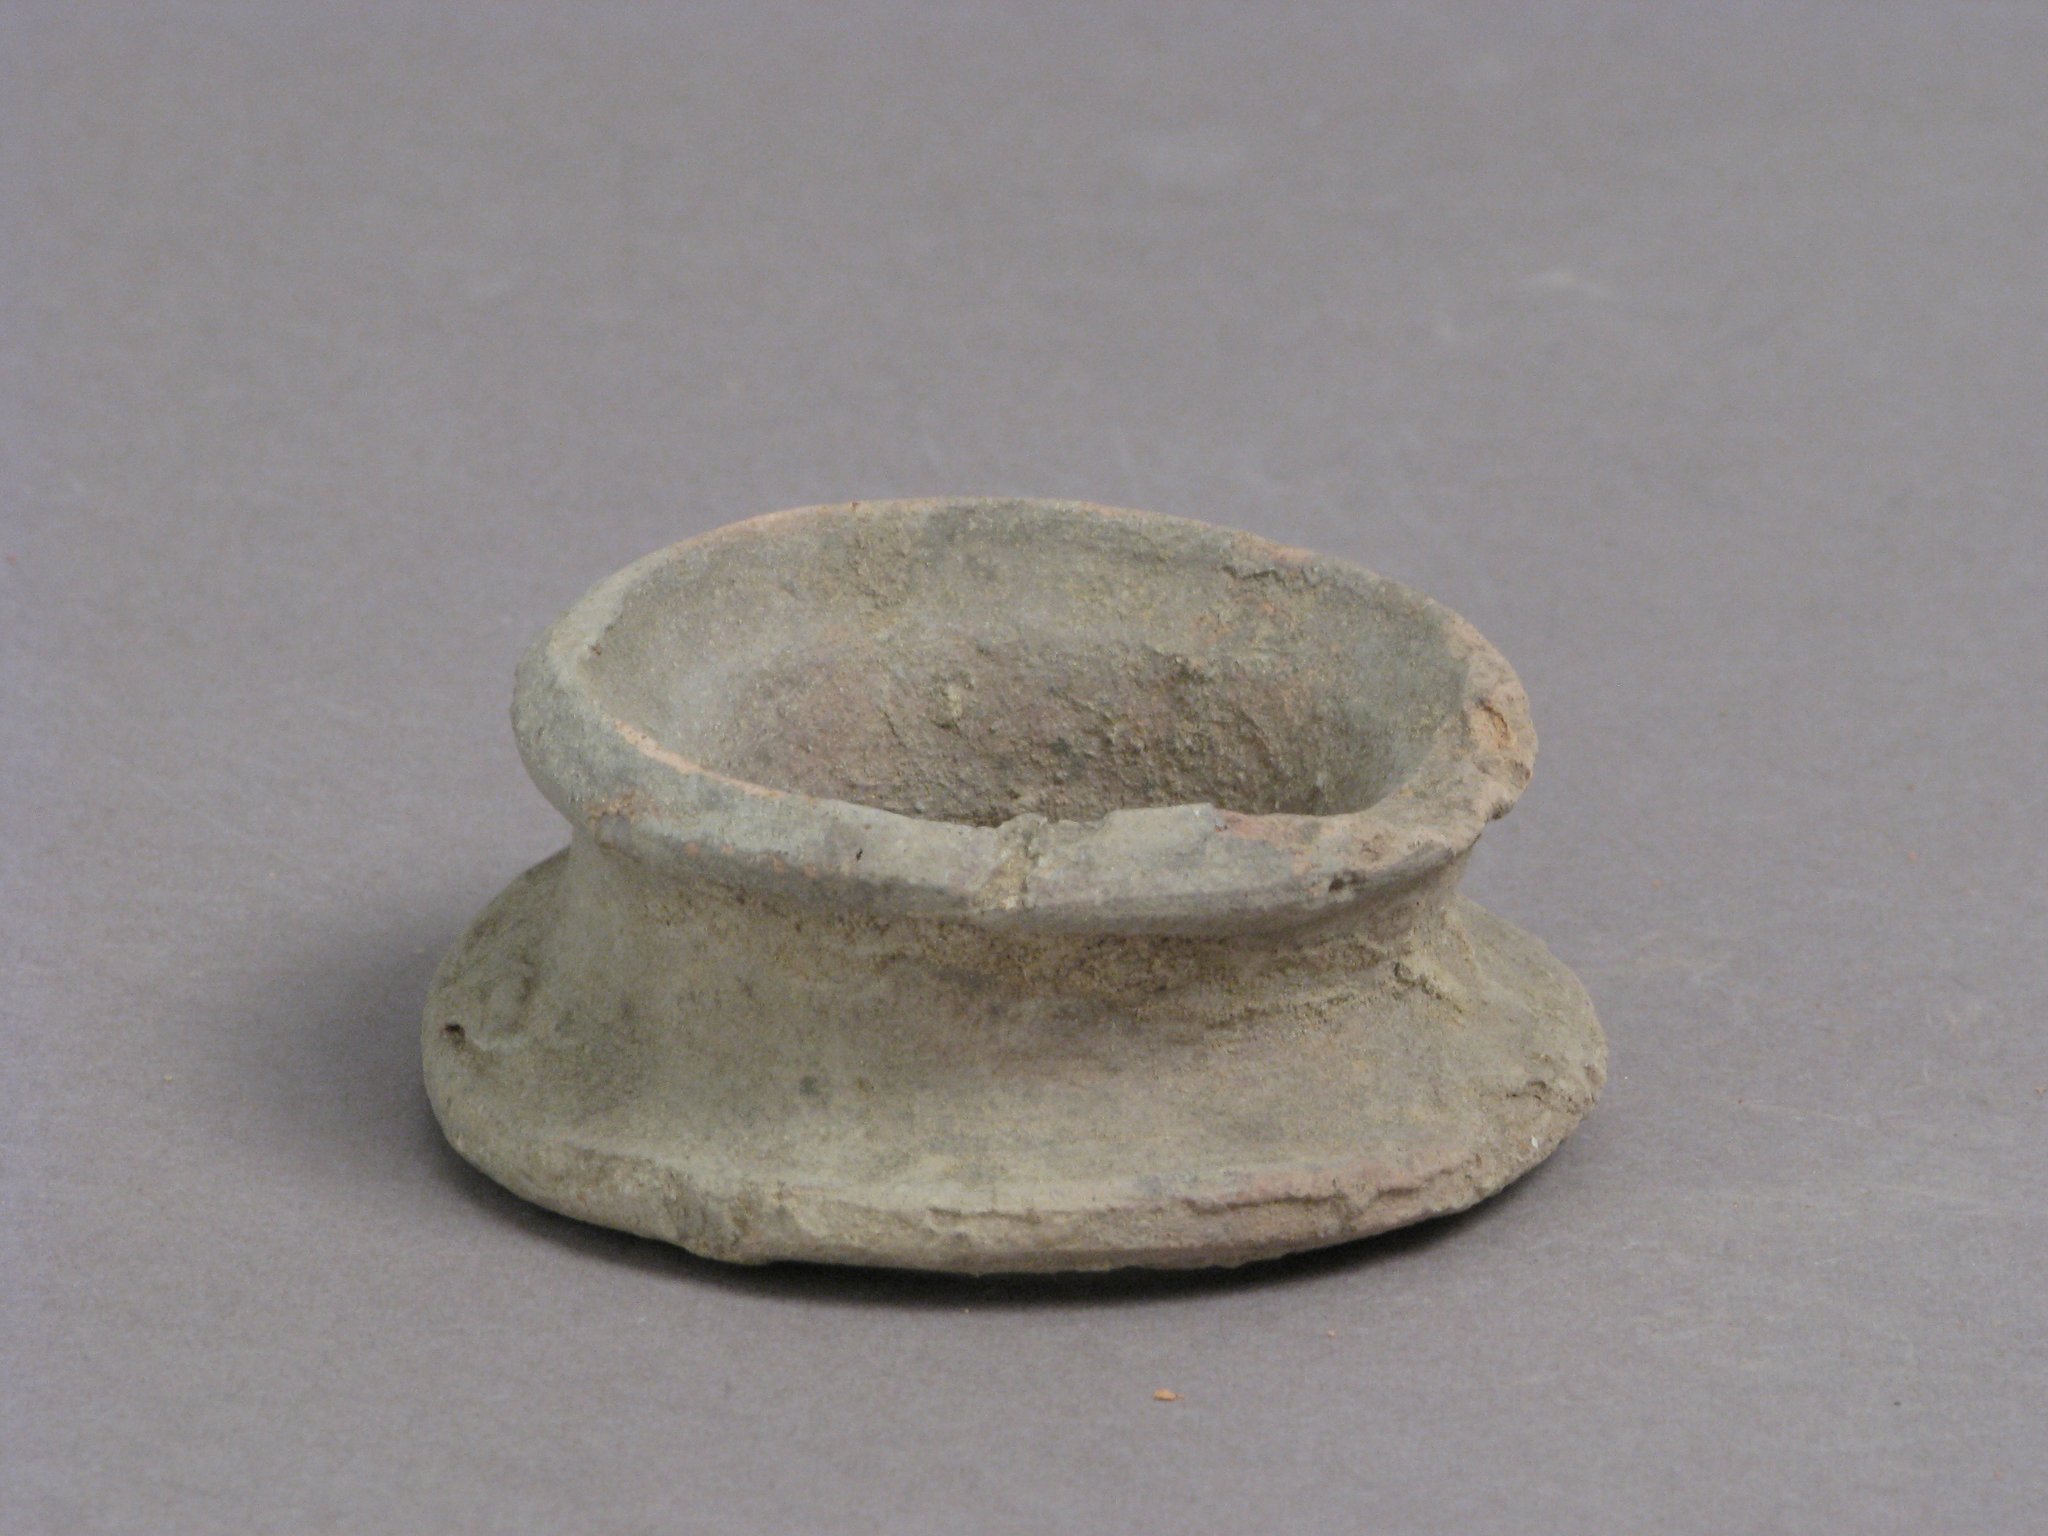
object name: ring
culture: coptic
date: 301-700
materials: earthenware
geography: egypt